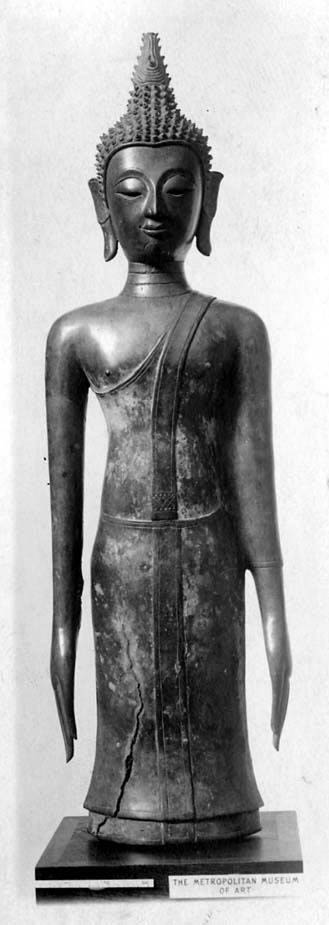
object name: figure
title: Standing Buddha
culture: thai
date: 1401-1500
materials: bronze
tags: buddhism,buddha